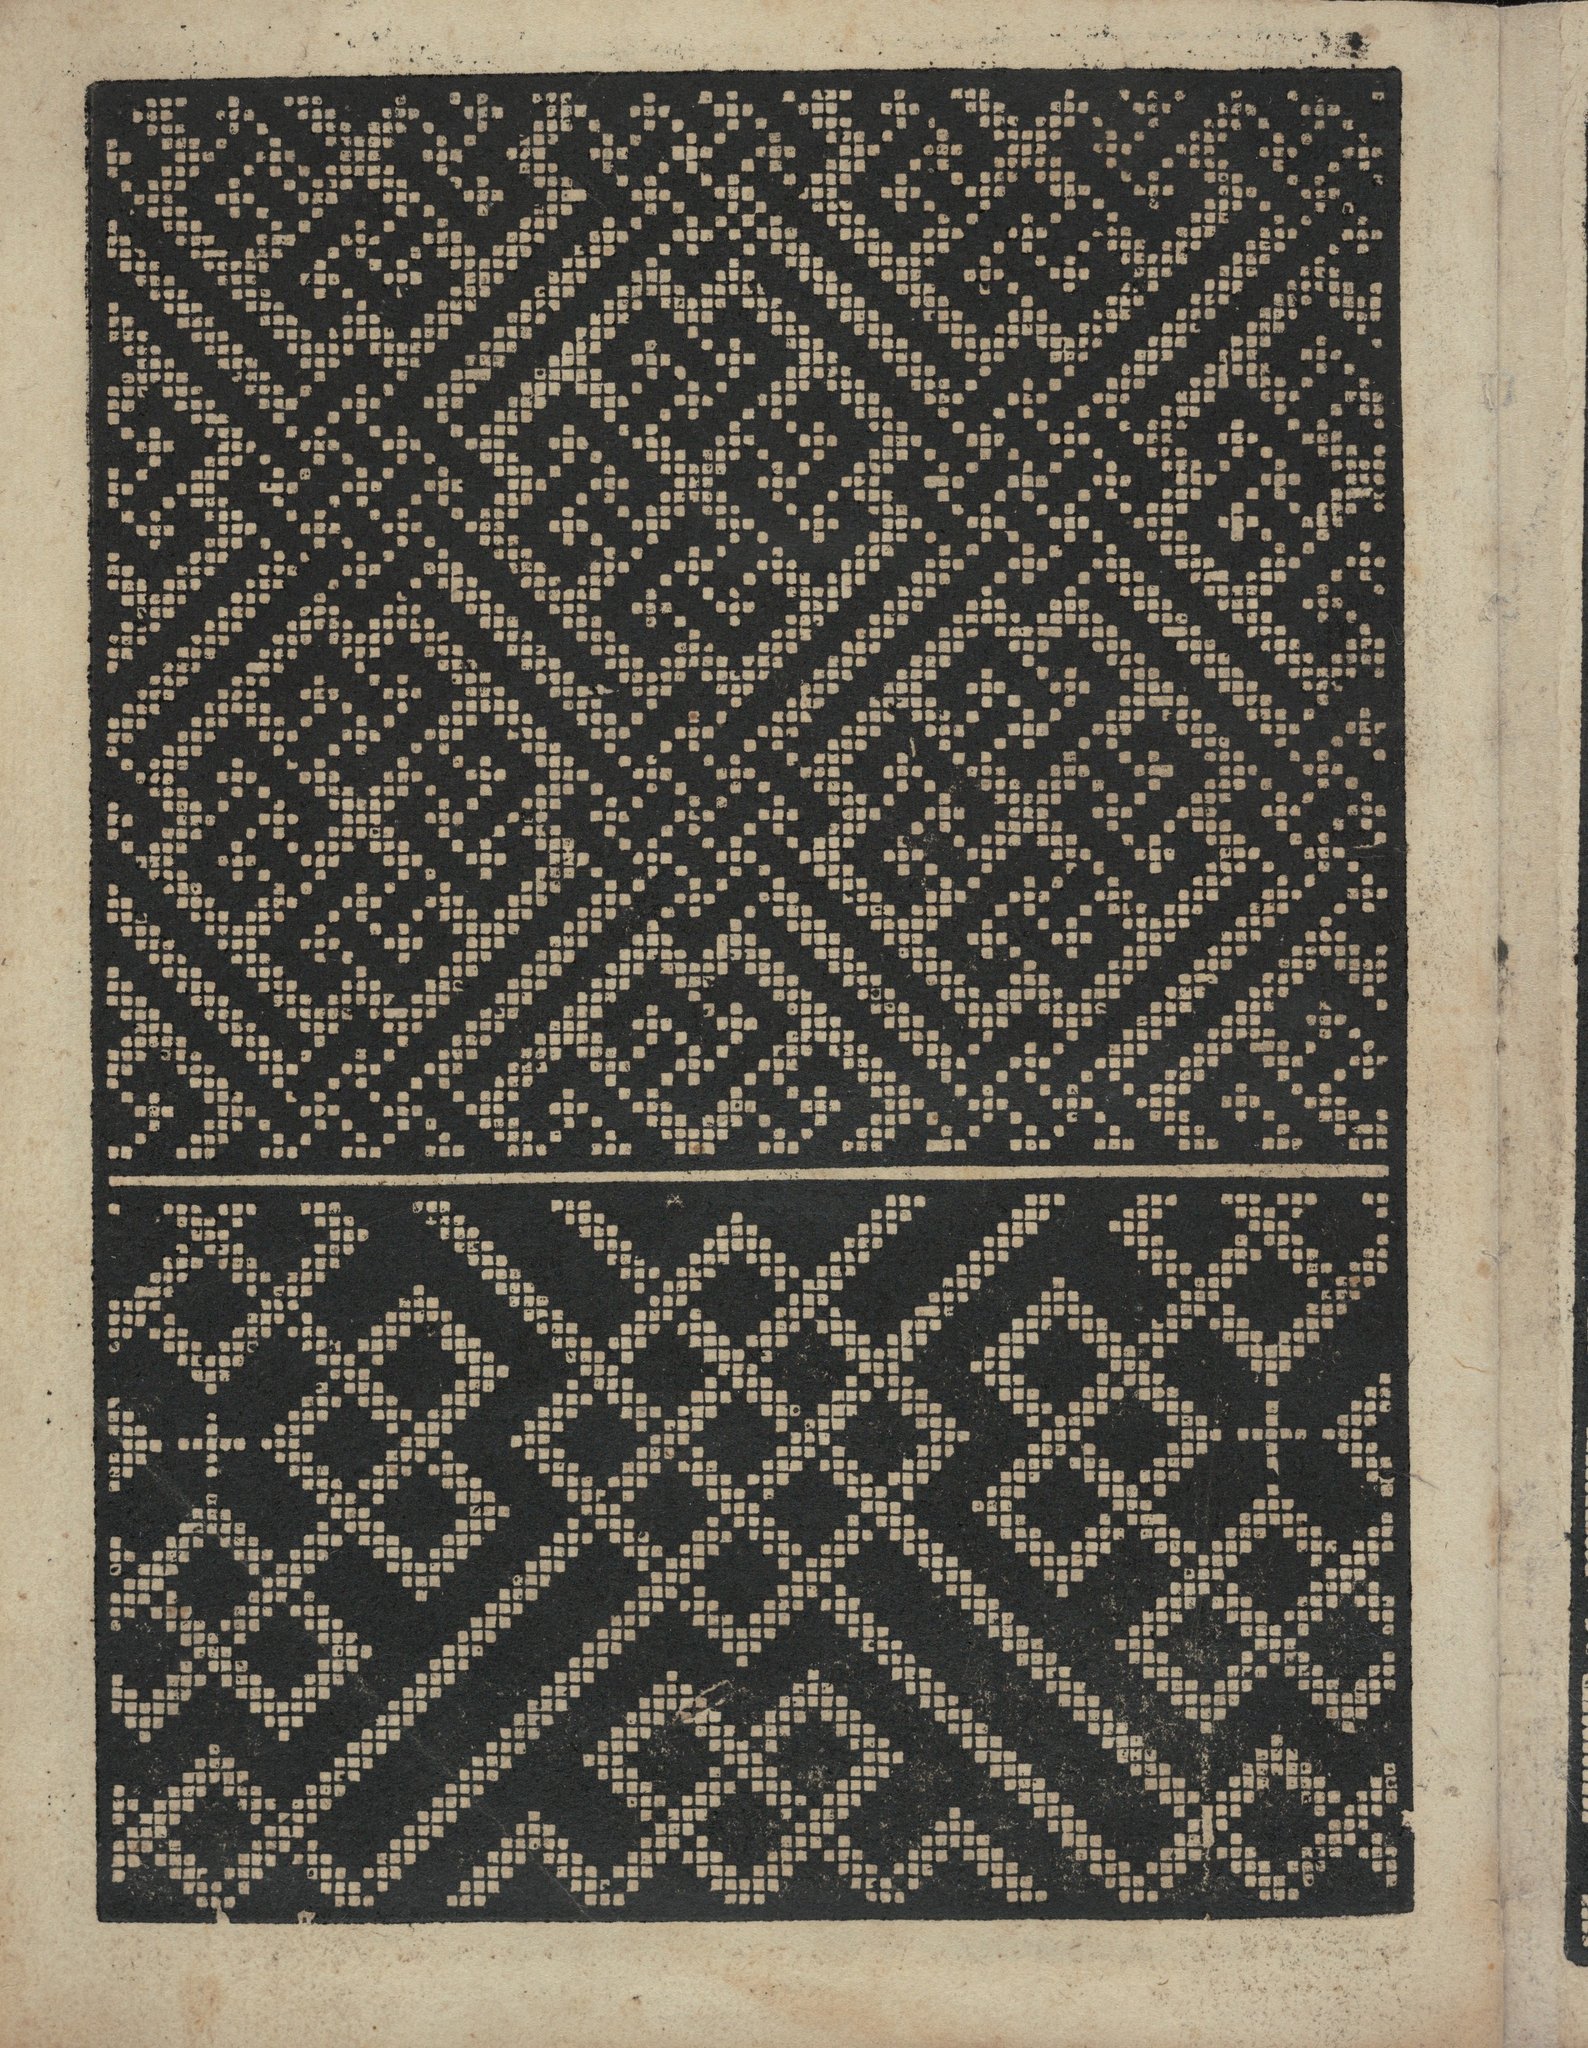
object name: book print ornament architecture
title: Libbretto nouellamete composto per maestro Domenico da Sera...lauorare di ogni sorte di punti, page 13 (verso)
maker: domenico da sera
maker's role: publisher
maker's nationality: french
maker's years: 1500-1599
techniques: woodcut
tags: ornament